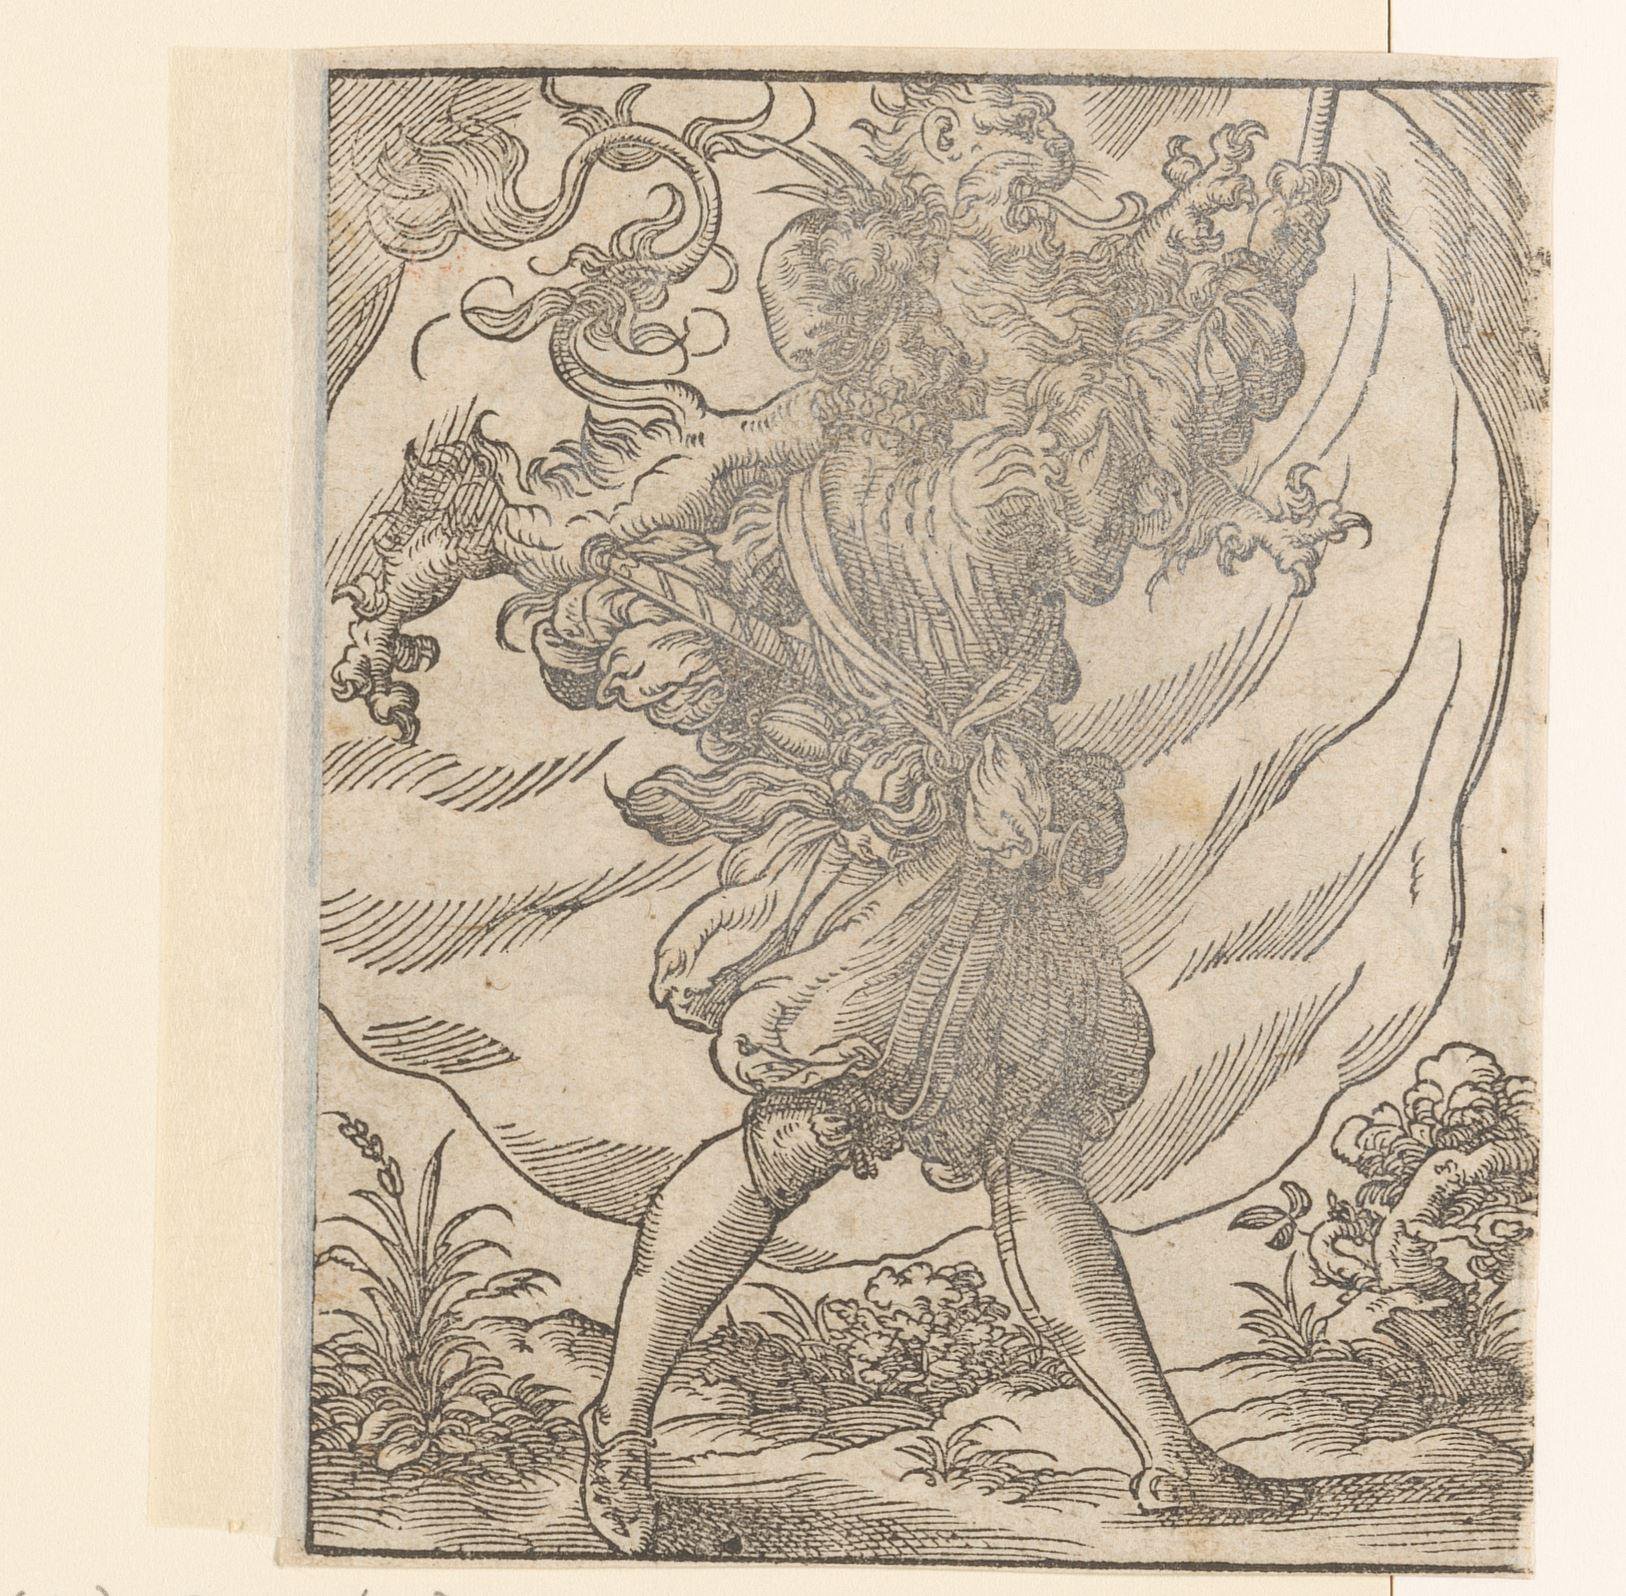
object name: print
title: Vaandeldrager met een vaandel waarop een leeuw staat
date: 1580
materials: paper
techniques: woodcut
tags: standard-bearer, flag-bearer, beasts of prey, predatory animals: lion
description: Prent ook gebruikt in: Amman, Jost. Kunstbüchlein. Frankfurt am Main: Feyerabend, 1580.